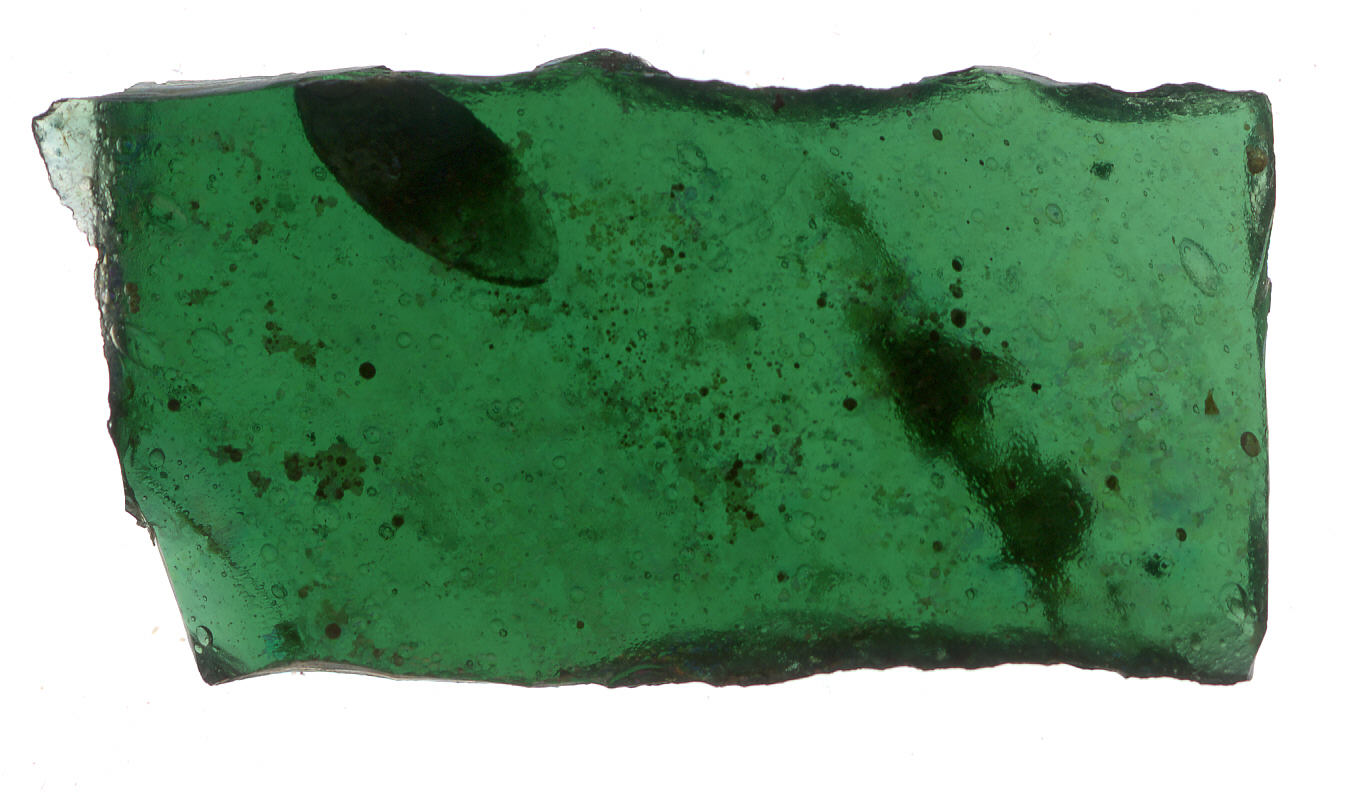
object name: fragment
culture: crusader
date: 1201-1300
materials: glass